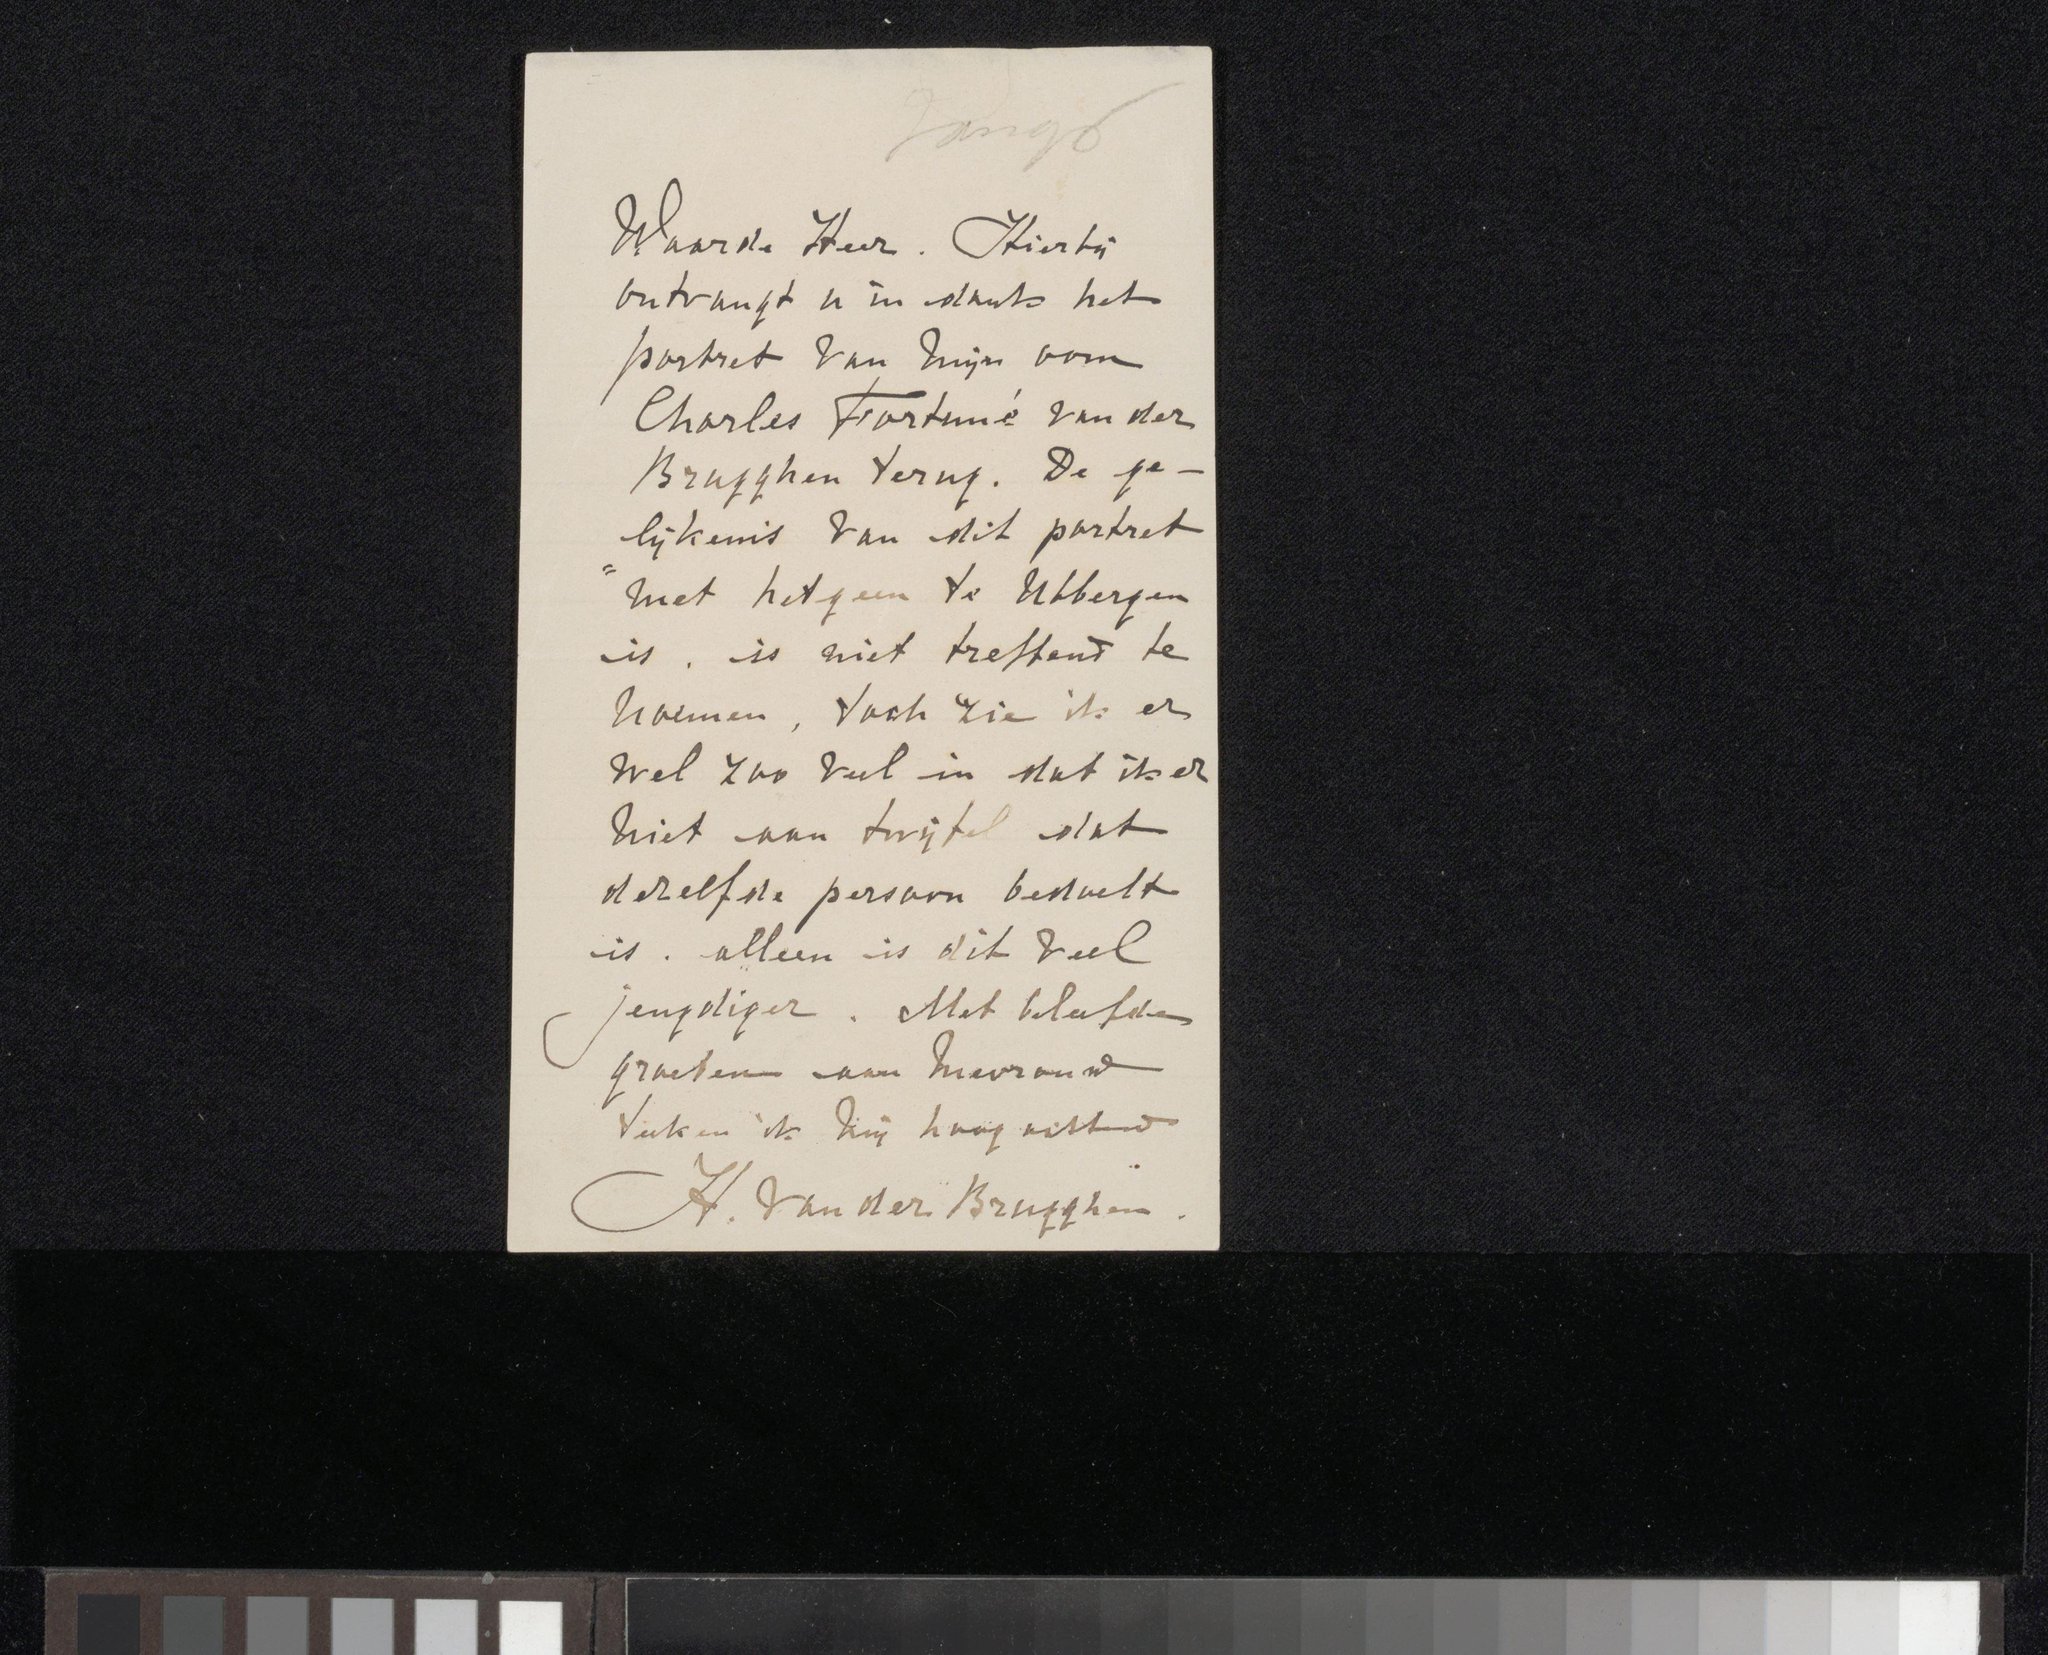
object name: letter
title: Brief aan anoniem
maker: Anonymous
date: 1850-1920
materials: ink, paper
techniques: pen, writing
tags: amsterdam, utrecht, painter, print maker, draughtsman, louis meijer, historical persons (portraits and scenes from the life)